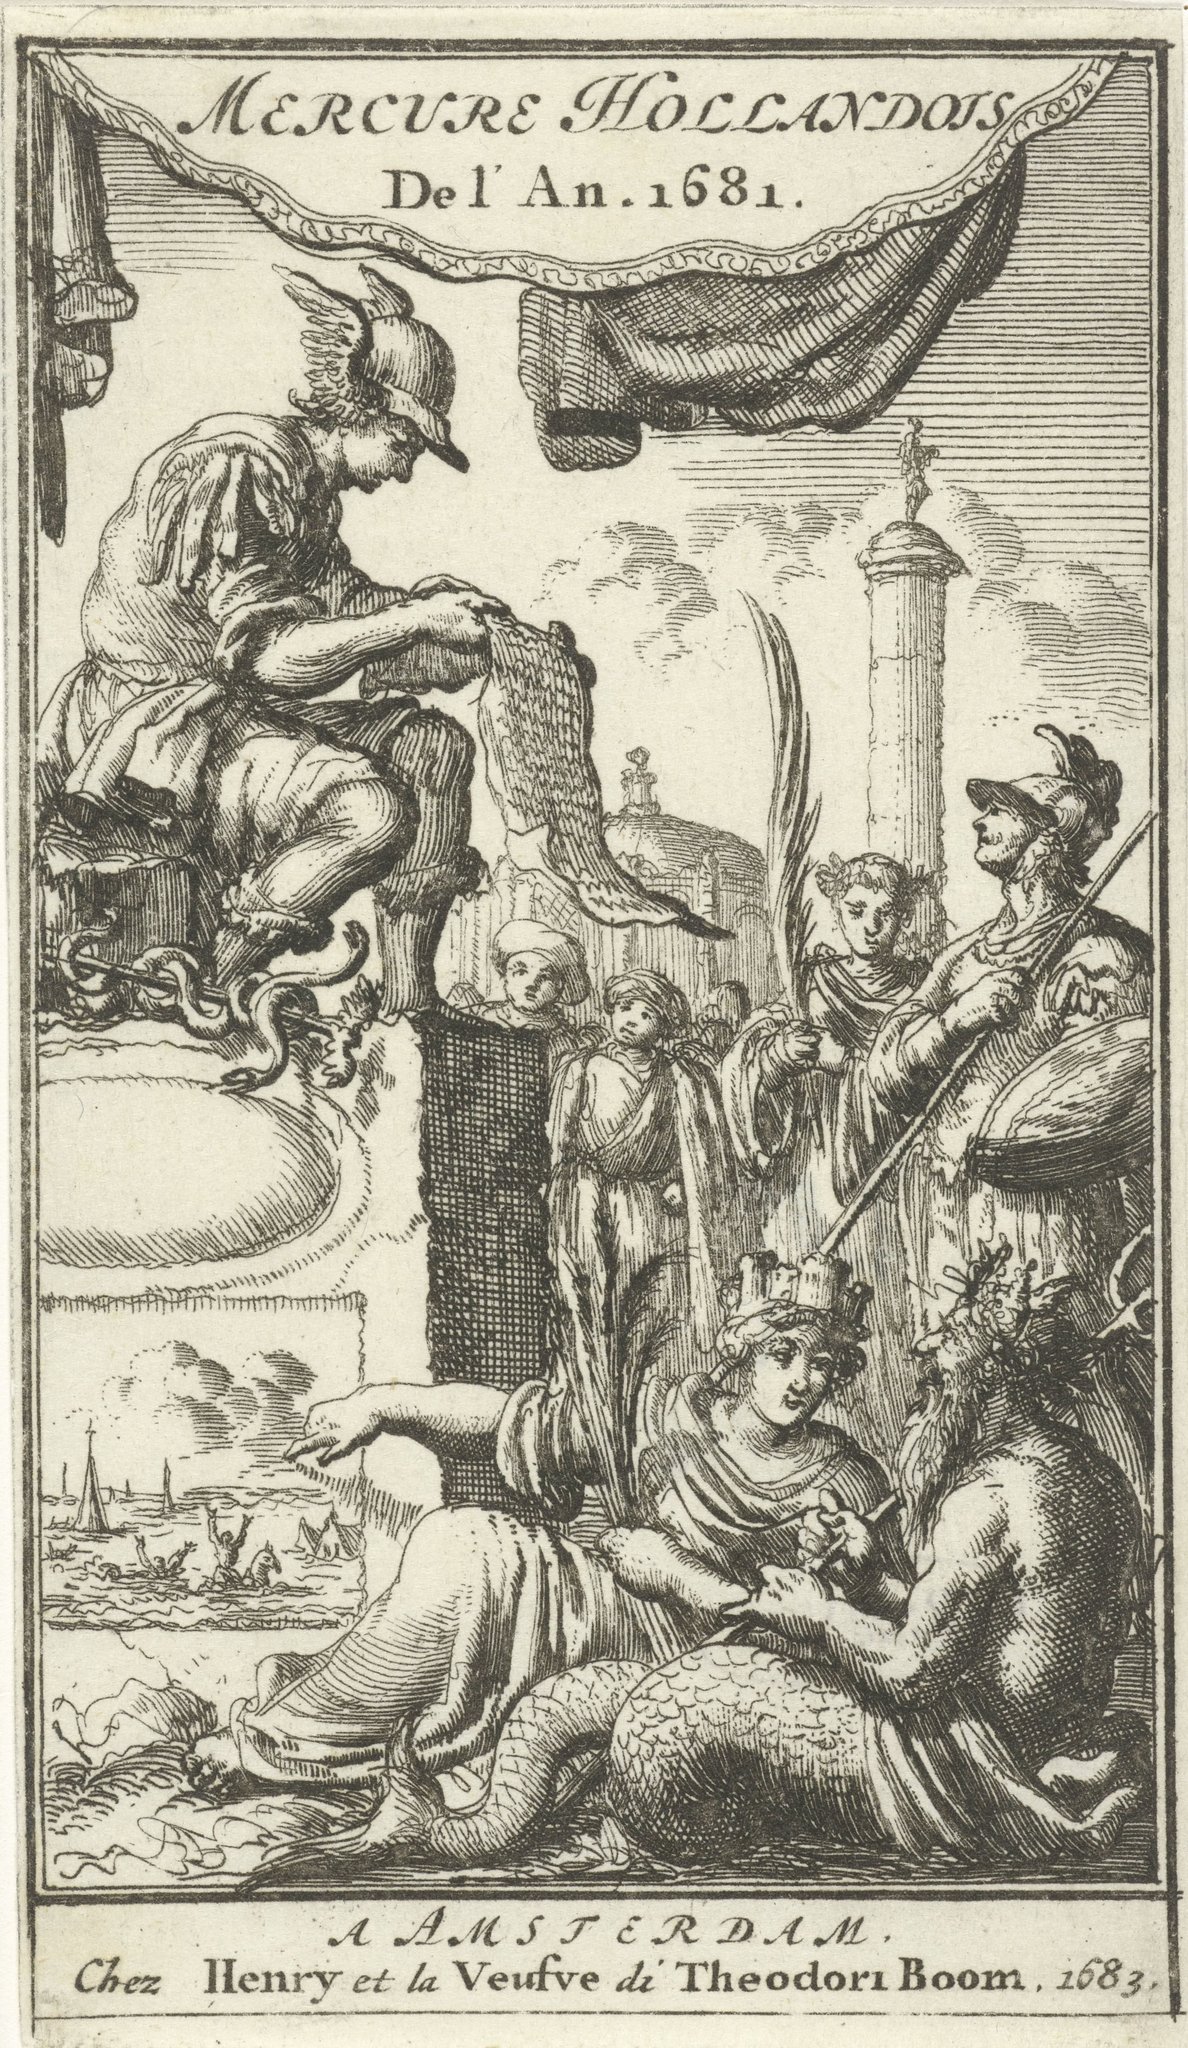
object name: titelblad, titelpagina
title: Titelpagina voor: Le Mercure hollandois, dl X, 1683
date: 1681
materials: paper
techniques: etching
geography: amsterdam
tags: (story of) ceres (demeter), (story of) mars (ares), triton(s), (story of) mercury (hermes), abundance; 'abondanza', 'abondanza maritima' (ripa), flood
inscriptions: collector's mark: Lugt 2228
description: Mercurius zit op een verhoging en leest een geschrift voor aan de personificatie van Overvloed, Mars, een triton en Ceres. Laatstgenoemde wijst op een reliëf met de voorstelling van een overstroming.